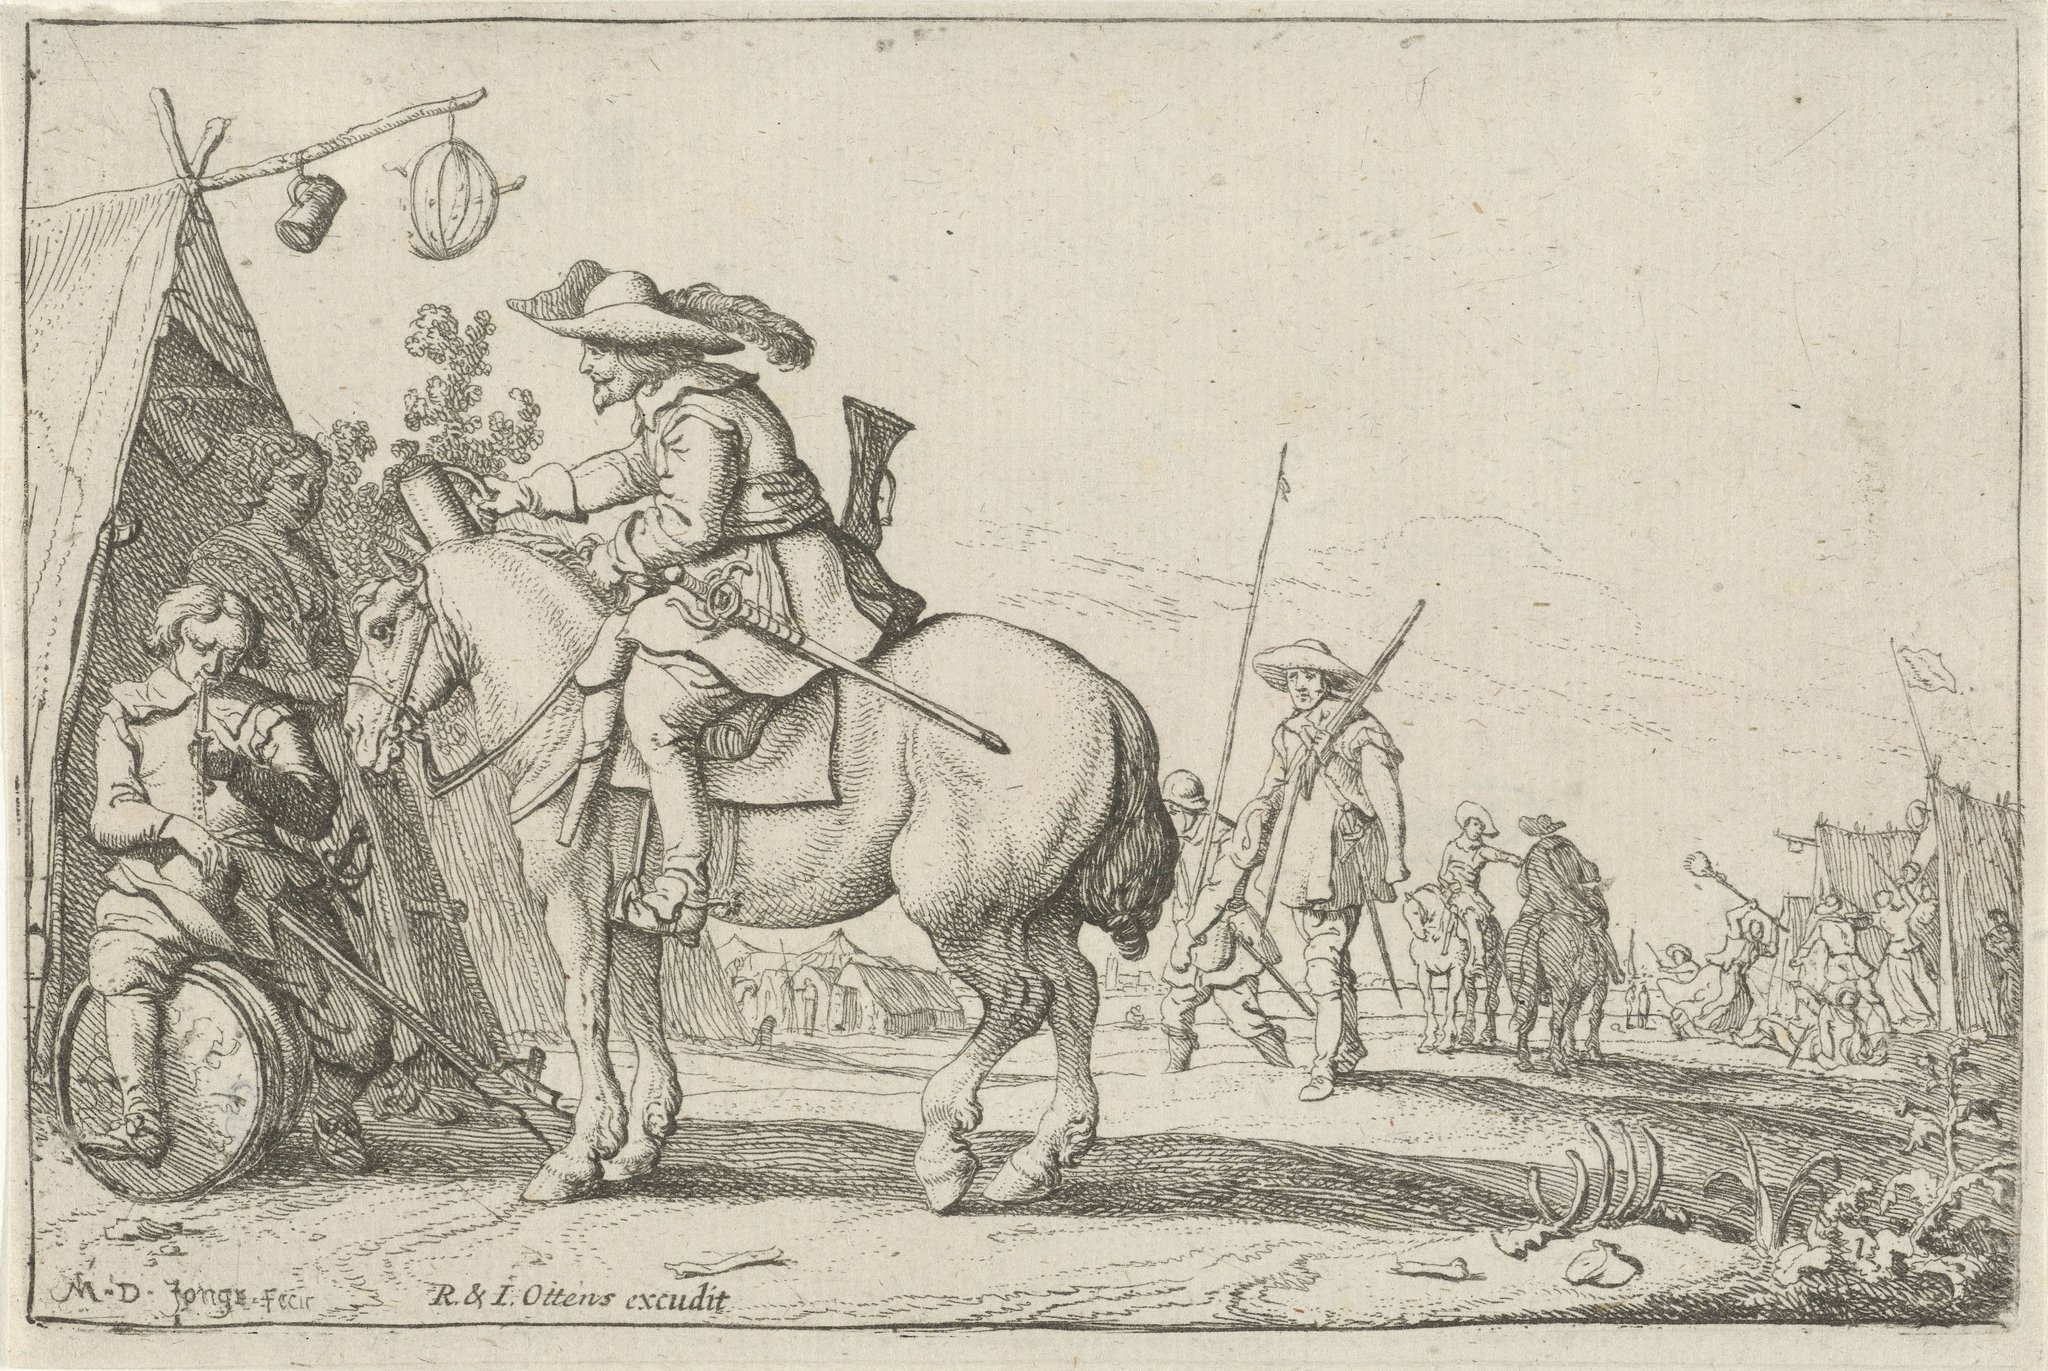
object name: print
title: Cavaleriegevechten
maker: jan martszen de jonge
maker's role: draughtsman, painter, print maker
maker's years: 1609-1647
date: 1619-1649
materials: paper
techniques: etching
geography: amsterdam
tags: (military) camp with tents, the soldier off duty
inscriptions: collector's mark: Lugt 2760, collector's mark: Lugt 2228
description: Een soldaat te paard voor een legertent overhandigt zijn drinkbeker aan een vrouw. Ernaast zit een rokende soldaat op een ton. Op de achtergrond een legerkamp met vele figuren, links vindt een gevecht plaats.